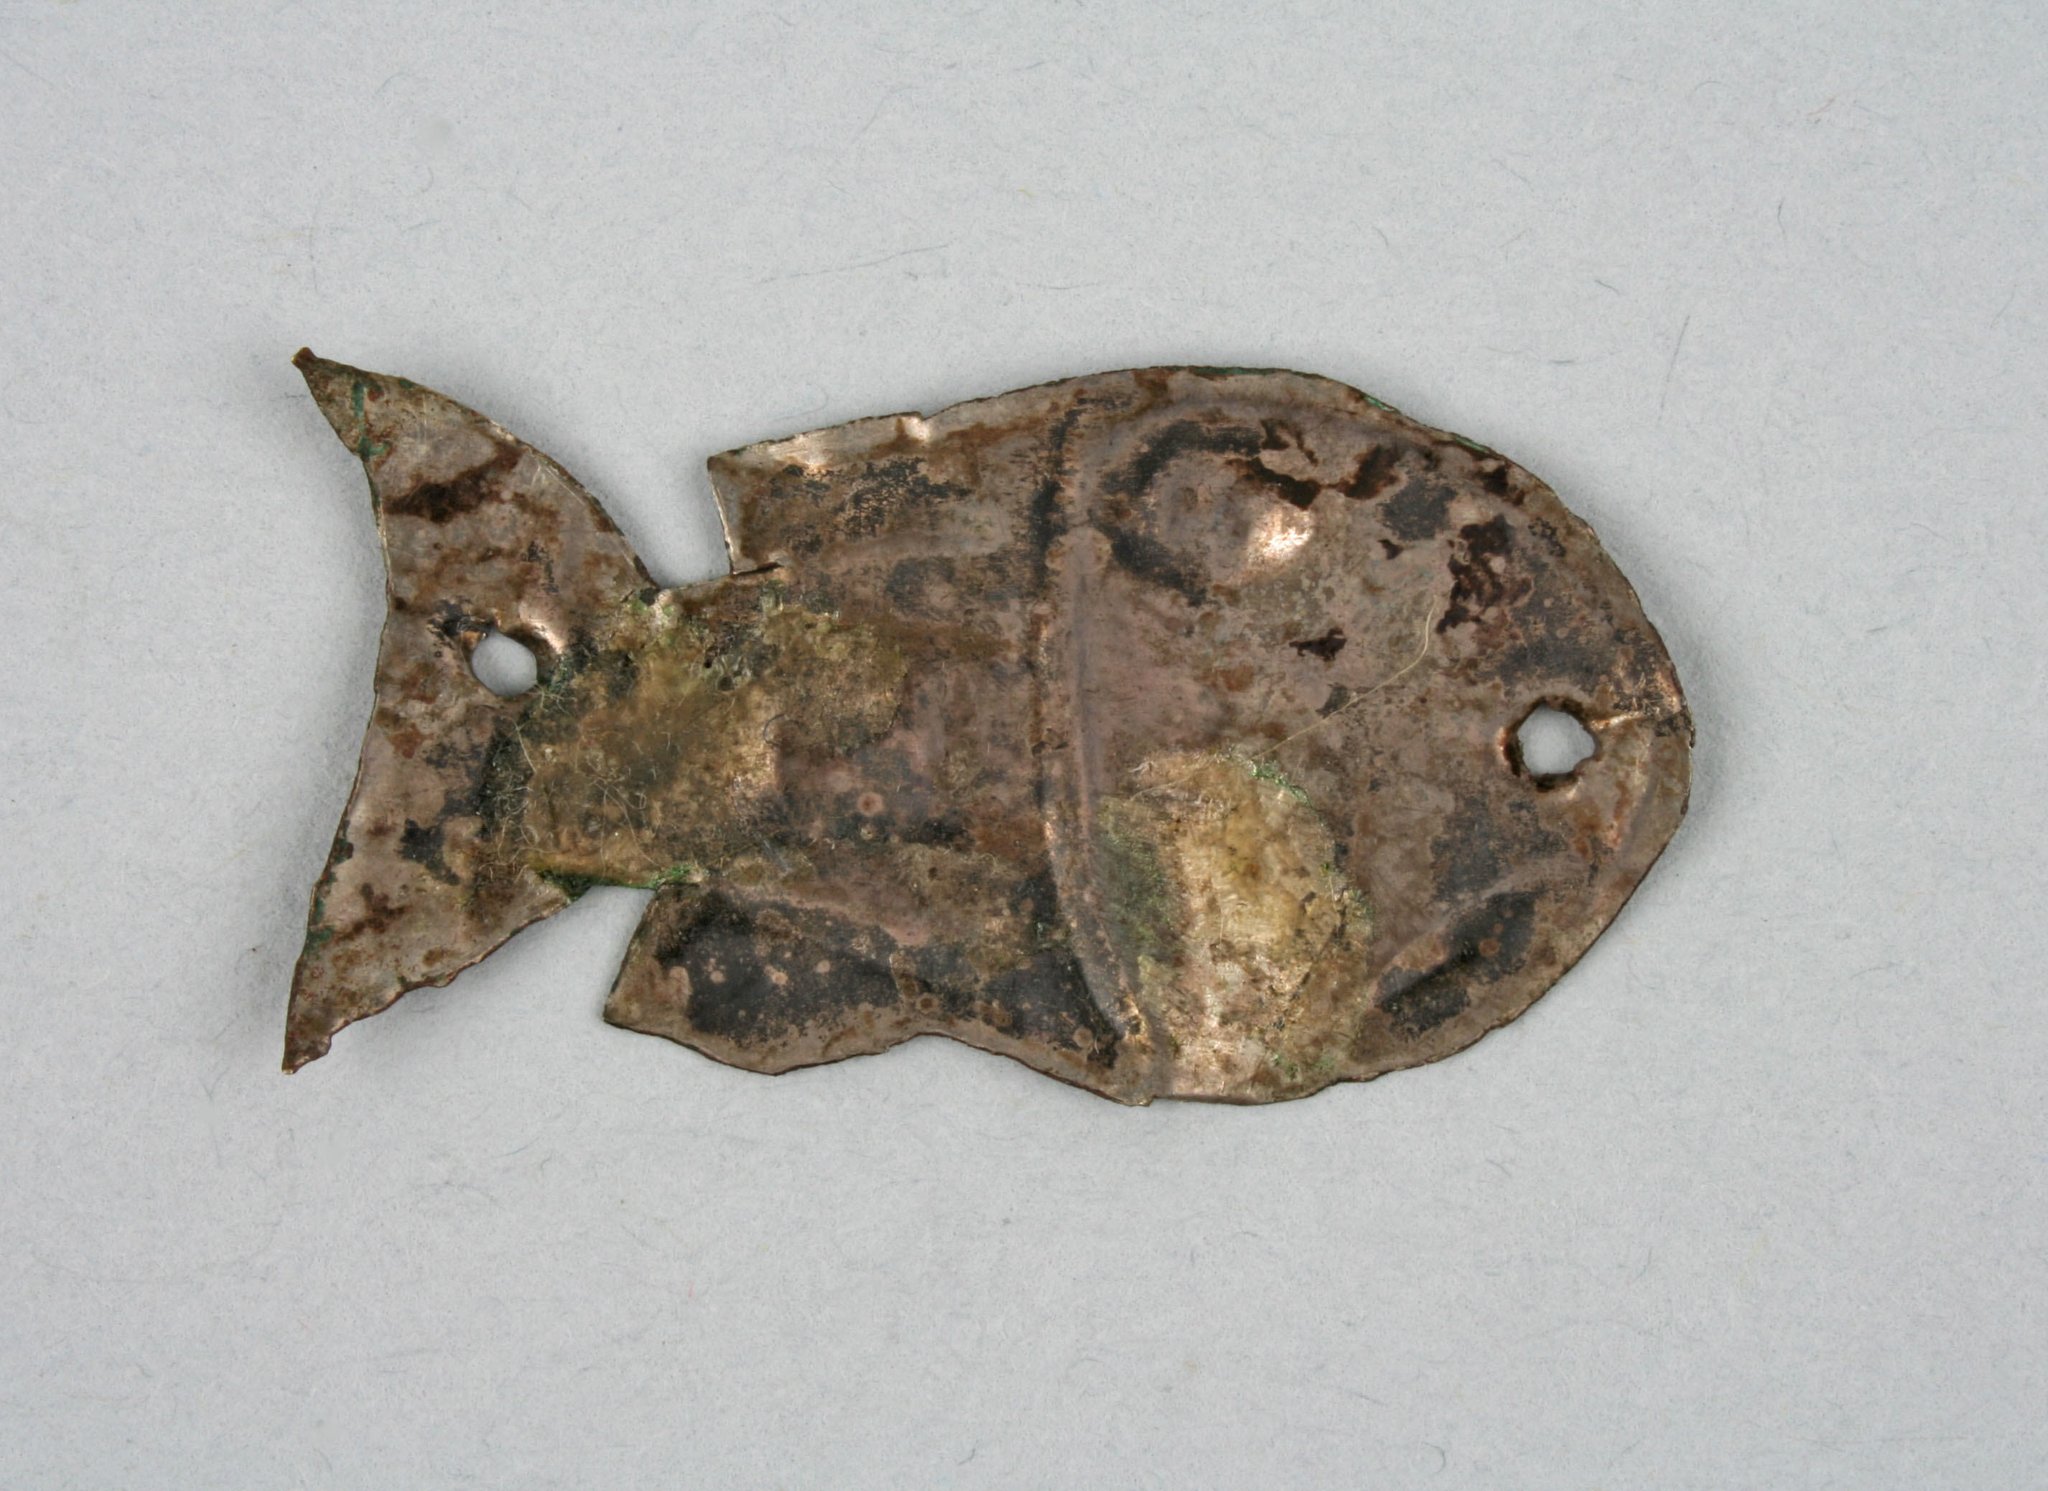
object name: ornament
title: Costume Ornament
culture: central coast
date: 1001-1200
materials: silver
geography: peru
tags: fish